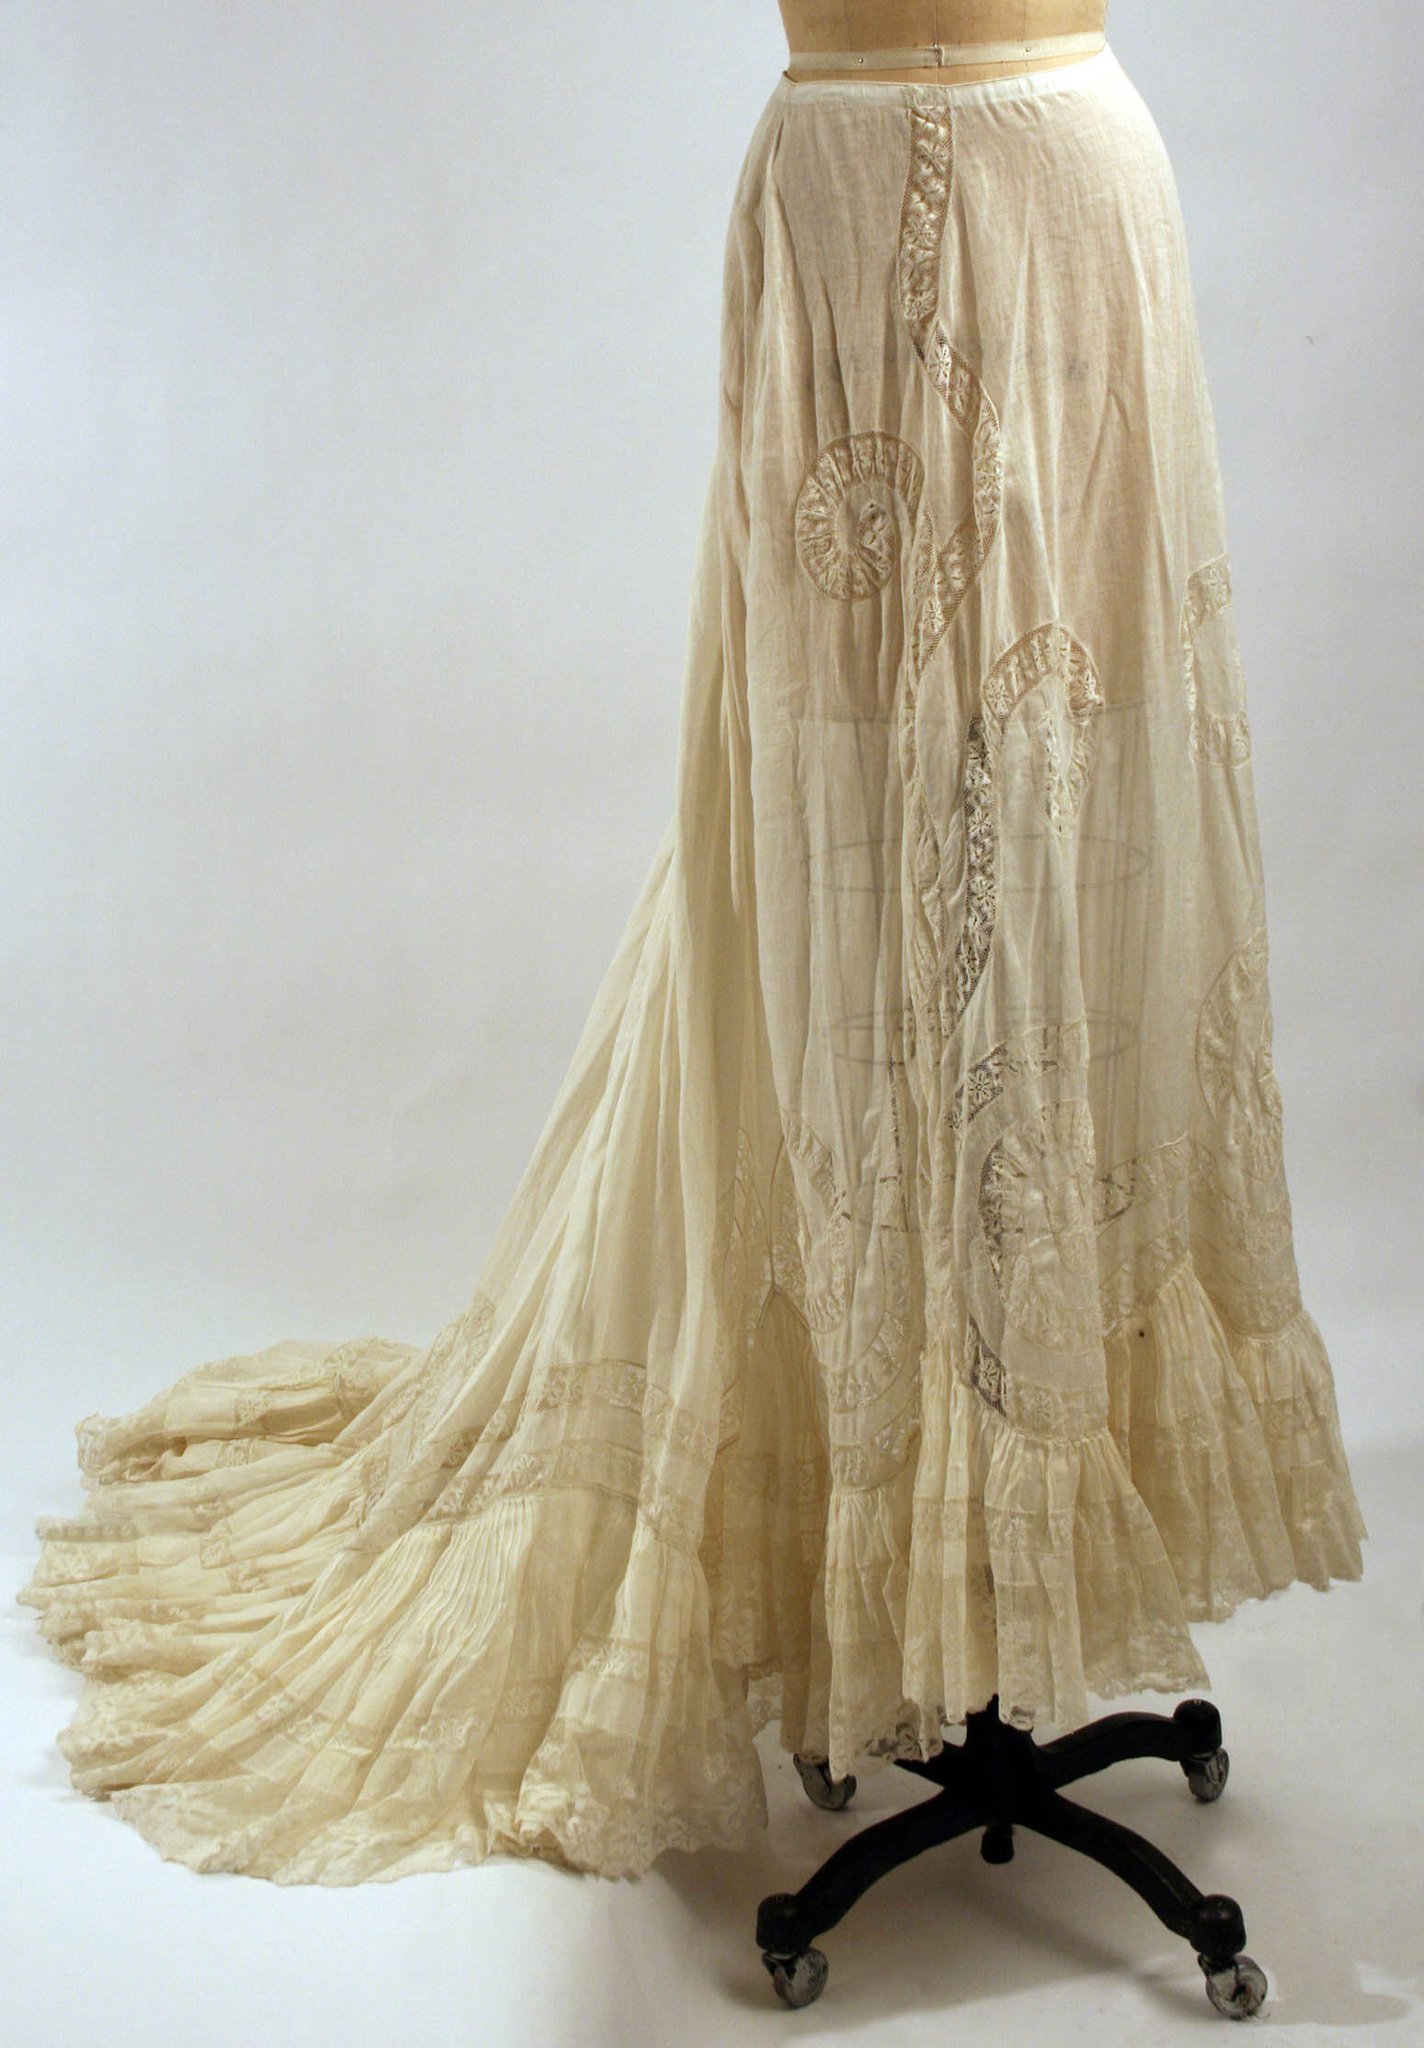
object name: underskirt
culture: american or european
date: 1900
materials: cotton